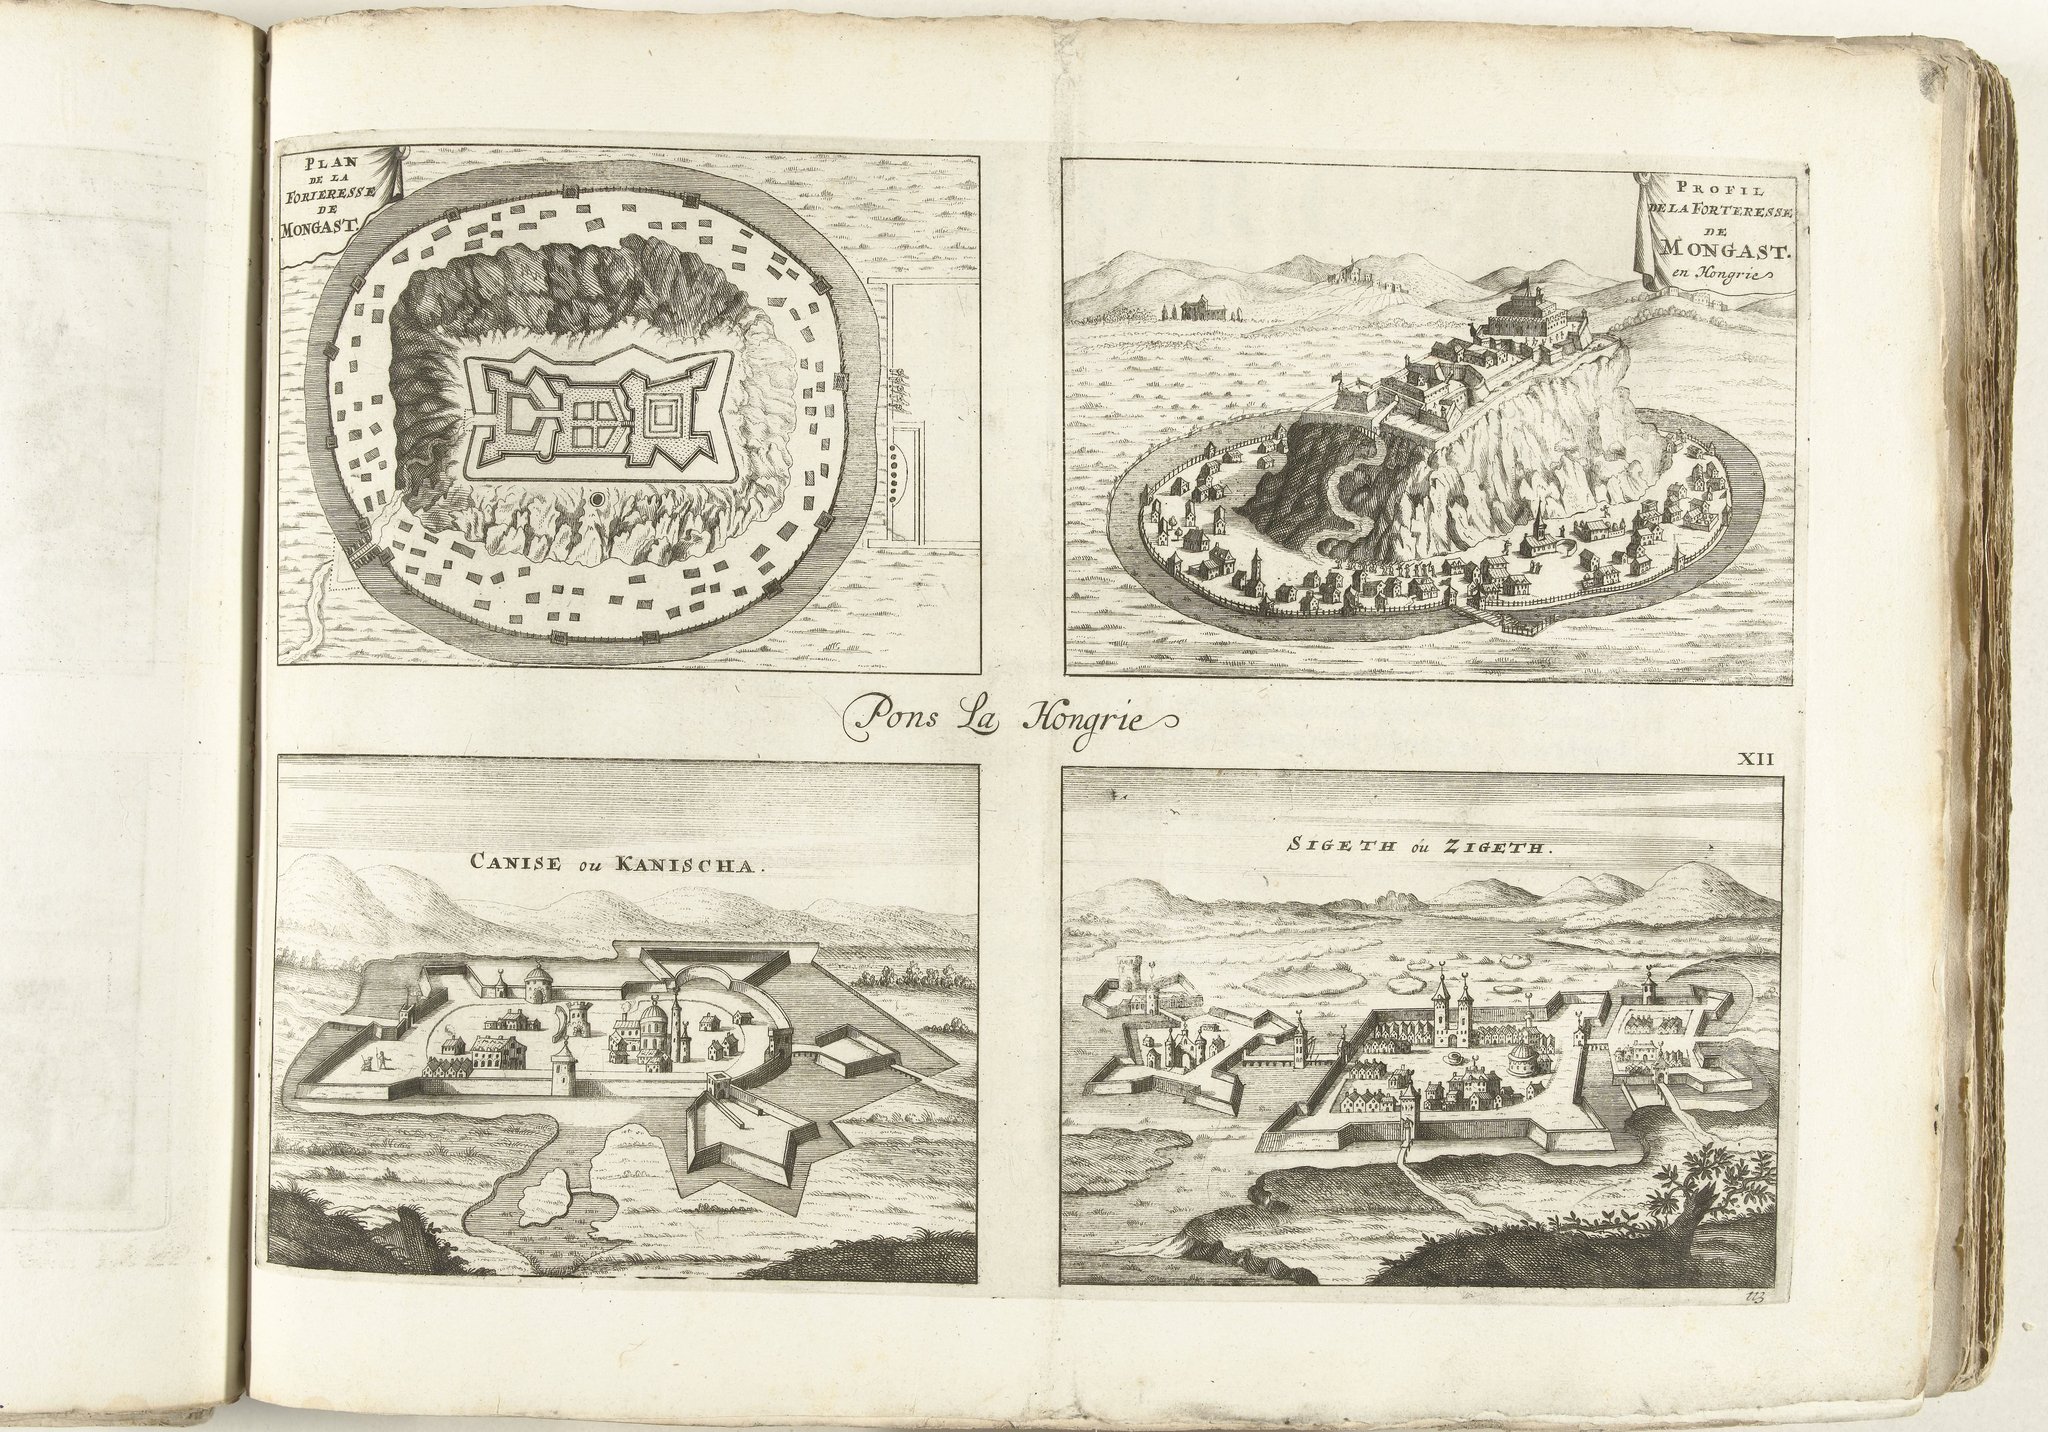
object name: map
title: Pons la Hongrie / Mongast / Canise ou Kanischa / Sigeth ou Zigeth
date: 1702-1703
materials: paper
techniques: etching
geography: northern netherlands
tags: mukachevo, oost-europa, sziget, spaanse successieoorlog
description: Blad met vier gezichten op Oost-Europese steden. Plattegrond van en gezicht op de vesting Munkács of Mongats (Mukachevo) in Boven-Hongarije, het huidige Oekraïne en twee gezichten op Kanischa en Sziget. Plaat nr. 113 in het prentwerk bestaande in totaal uit 276 genummerde platen van vermaarde sterke steden en vestingen in het kader van de Spaanse Successieoorlog. Voor het merendeel zijn deze platen gekopieerd naar de anonieme Franse platen: in Les forces de l'Europe en in: Le theatre de la guerre, dans les Pays-Bas, beide oorspronkelijk uitgegeven door Nicolas de Fer te Parijs (1693-1697) in het kader van de Negenjarige Oorlog. Titel en opschriften in de plaat in het Frans.